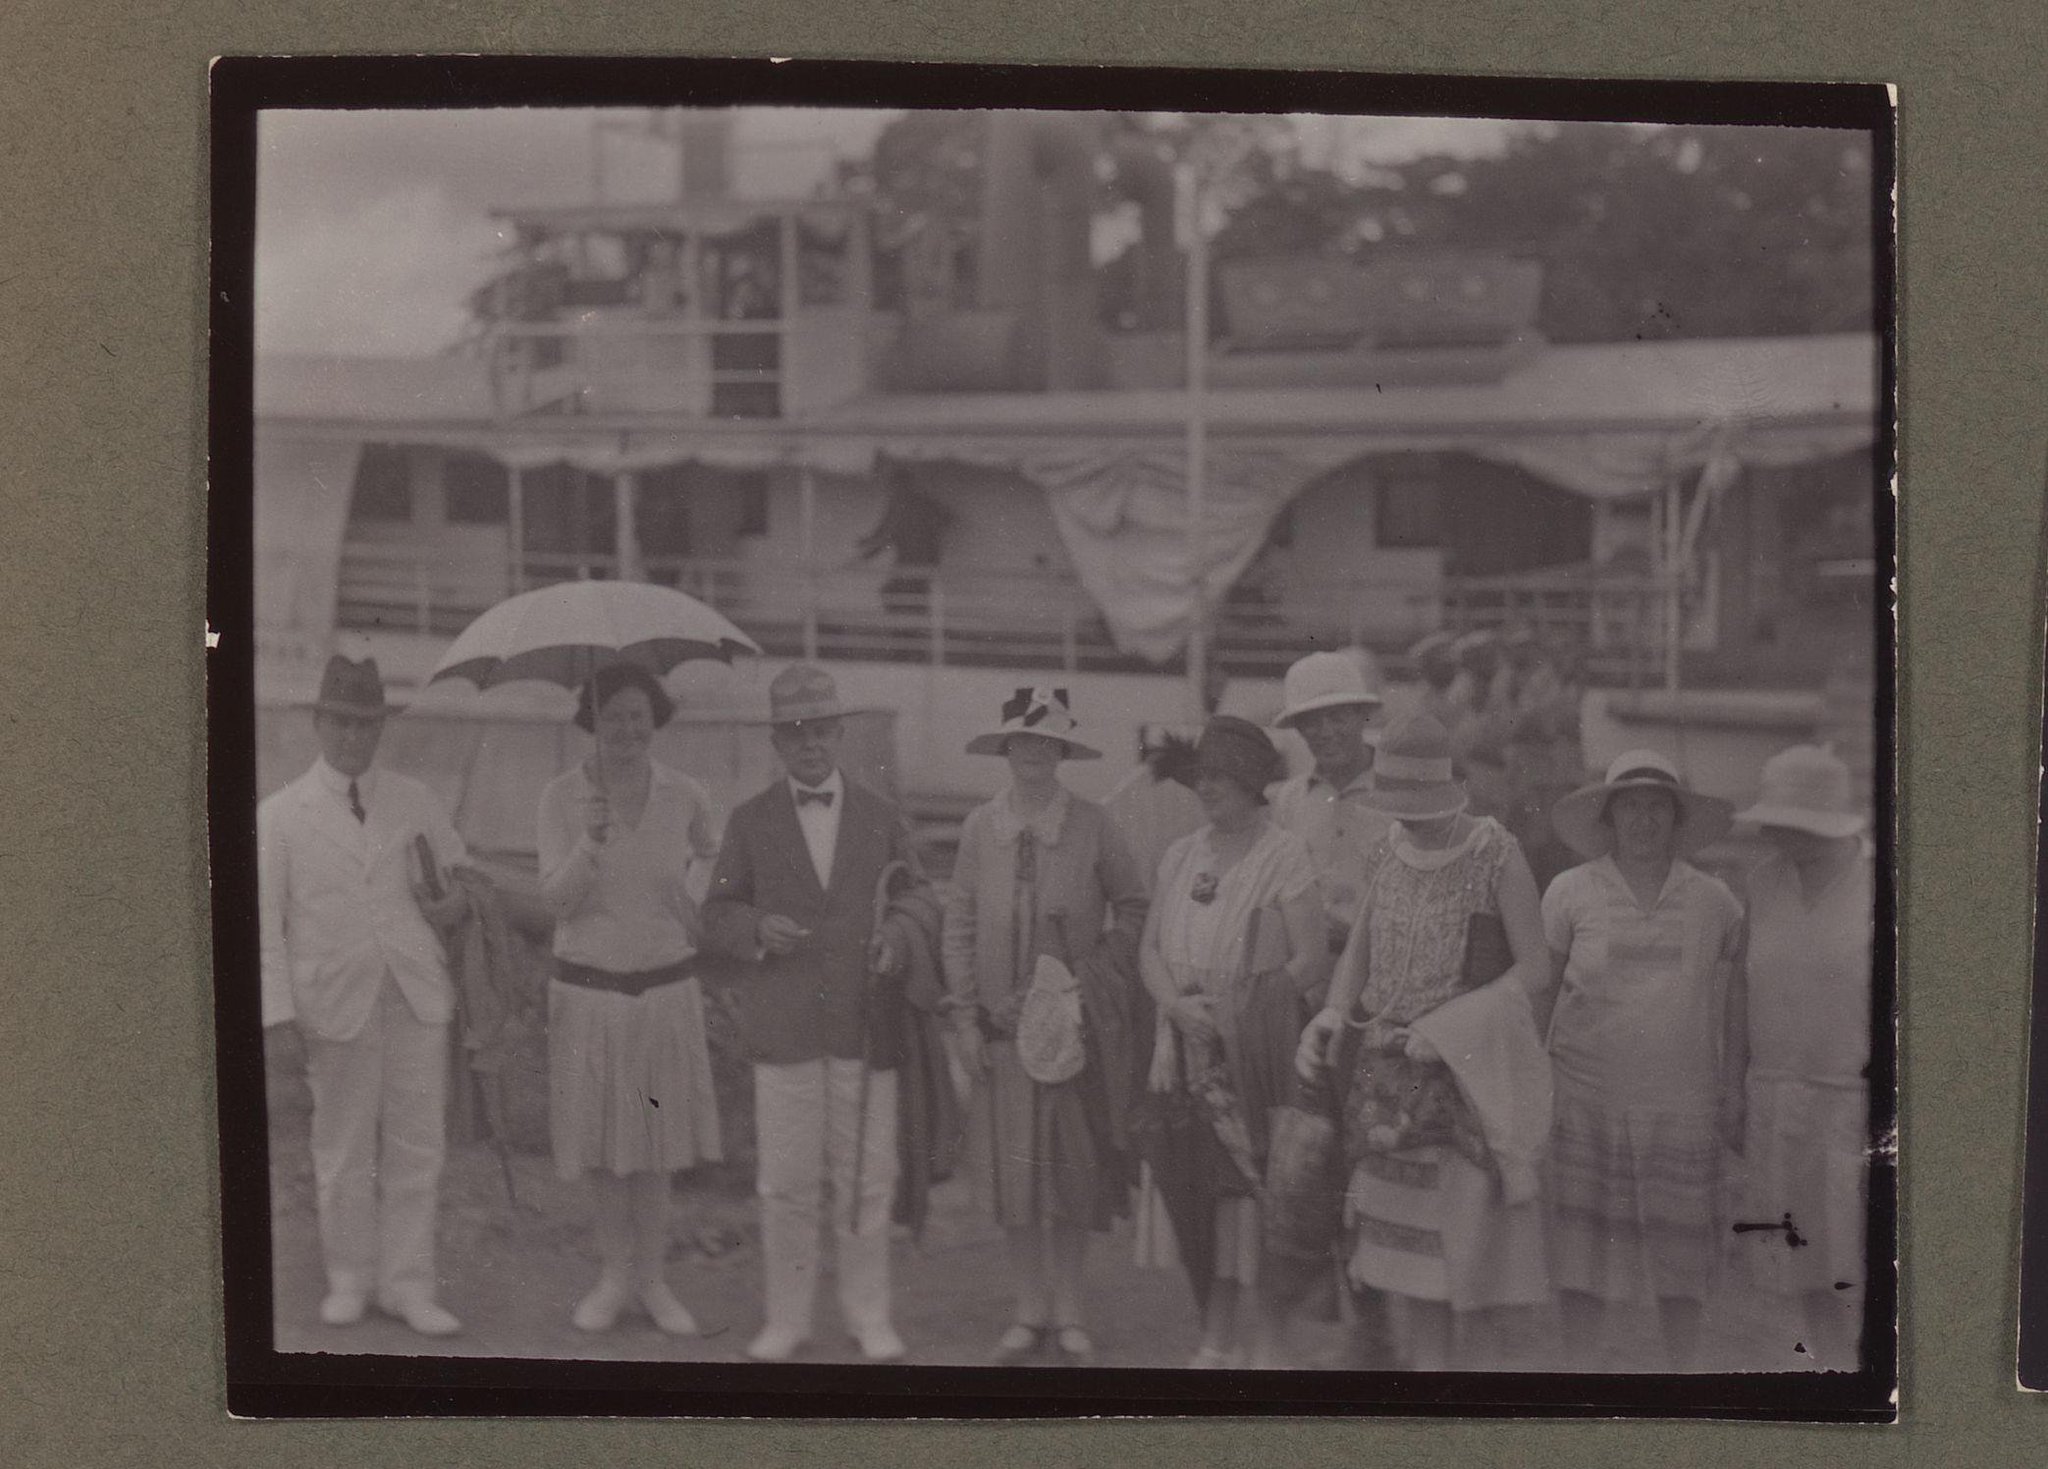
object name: photograph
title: Gezelschap voor boot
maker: Anonymous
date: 1925-1927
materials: photographic support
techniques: photography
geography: suriname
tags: jetten, familie, moengo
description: Groepsfoto van een gezelschap voor een boot. Foto op een bladzijde van een los albumblad. Onderdeel van het ensemble met foto's van de familie van ingenieur Jetten in de mijnbouwstad Moengo in Suriname.